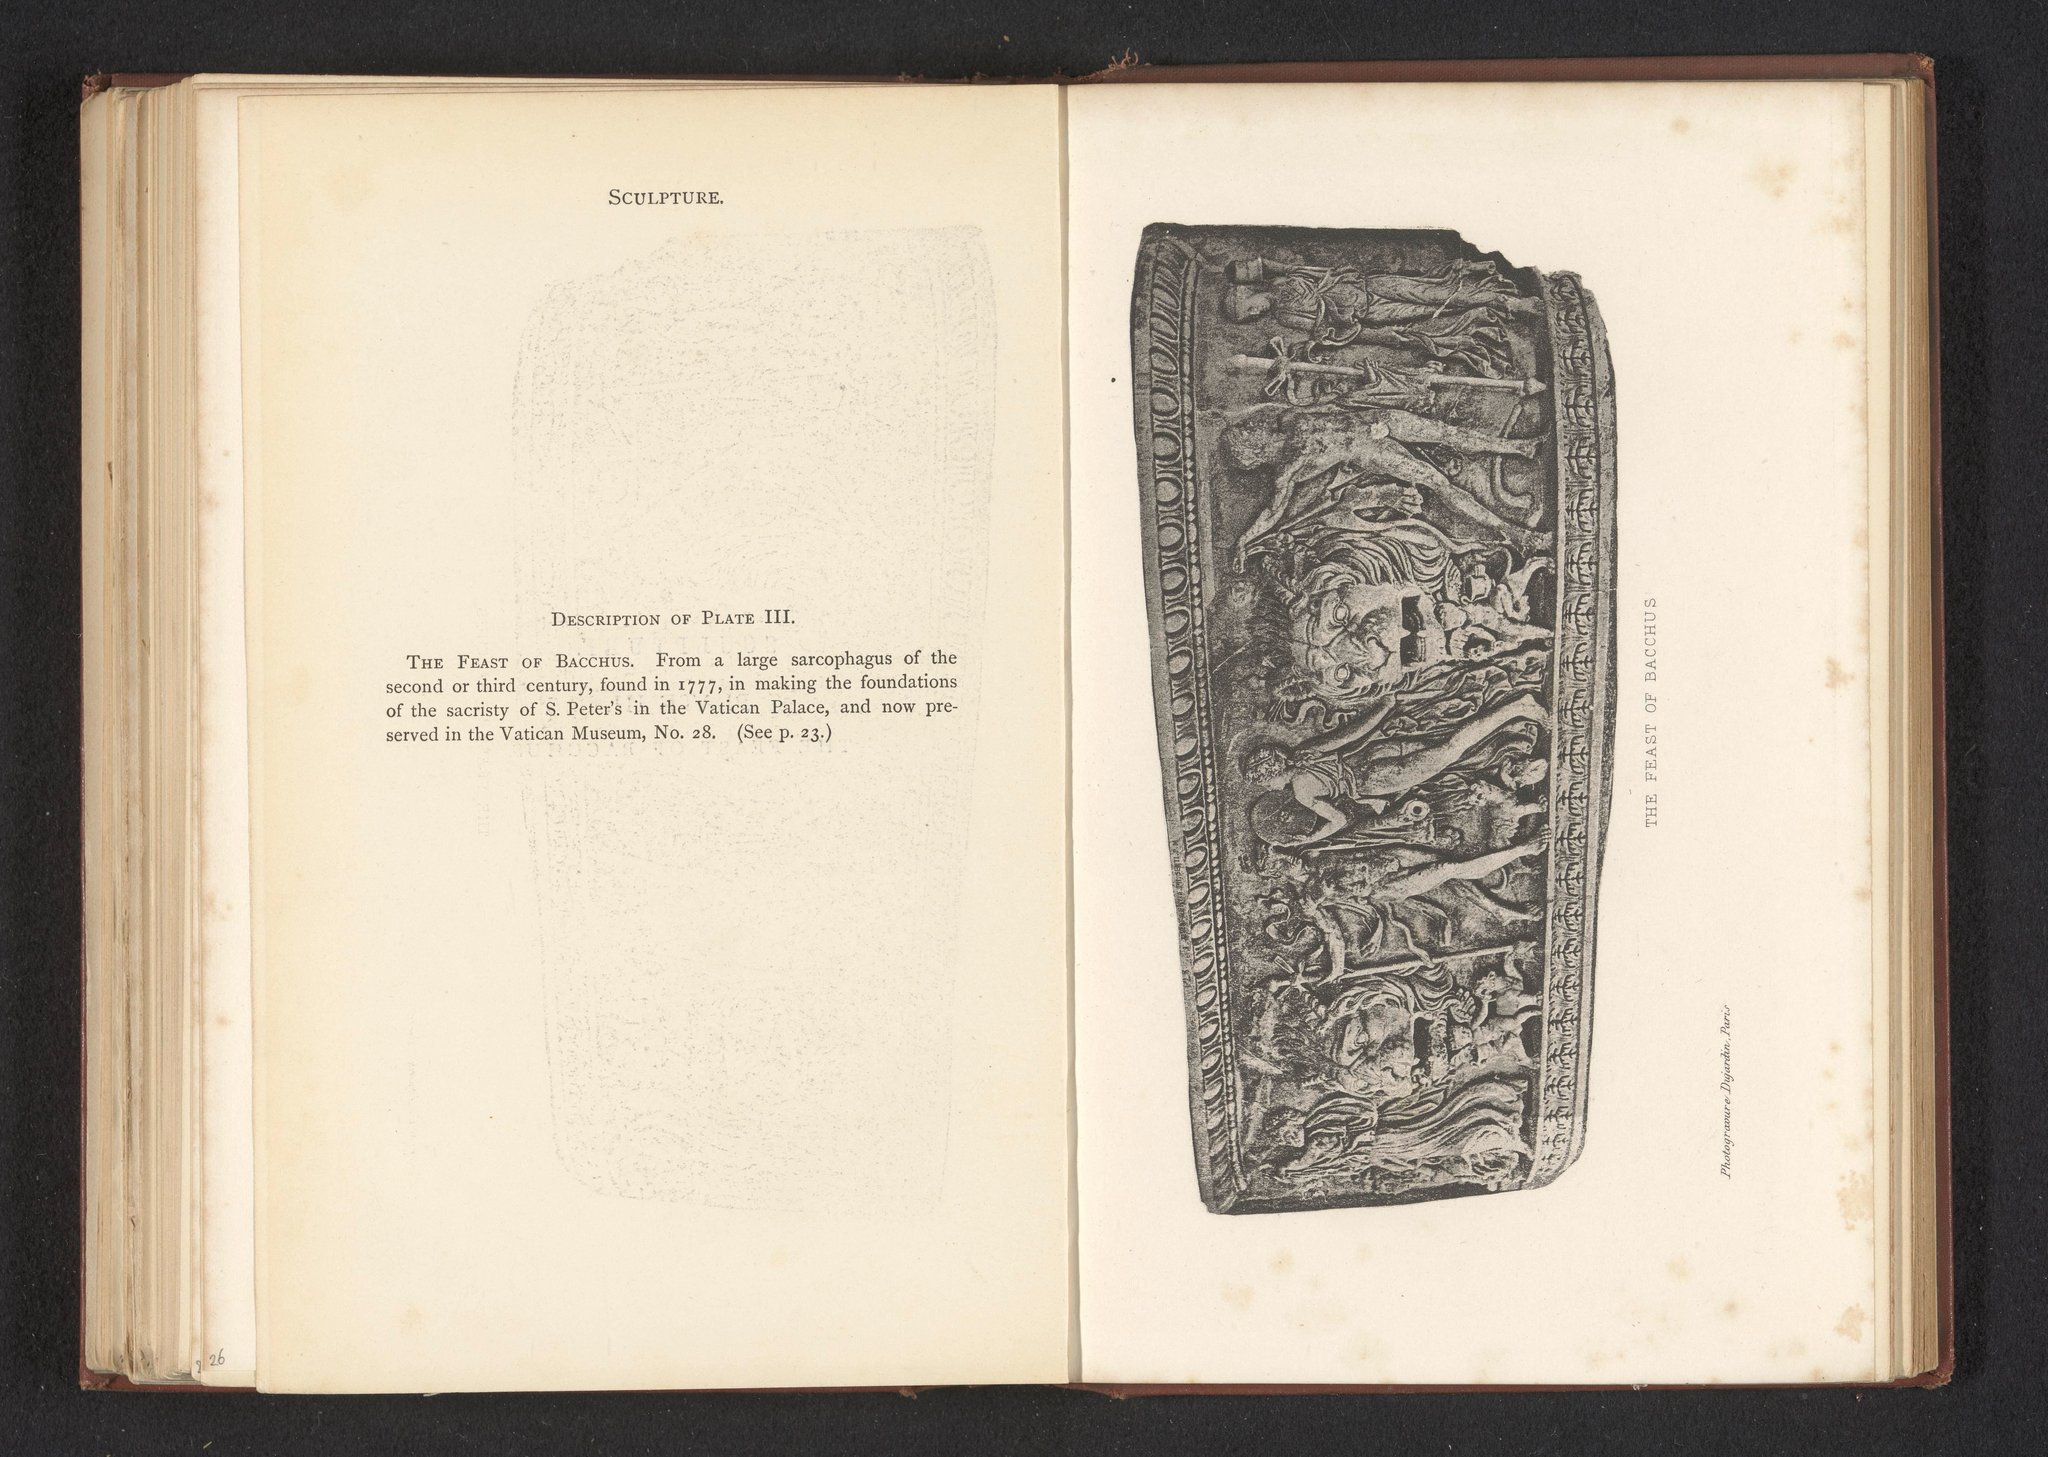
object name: page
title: Reliëf van een sarcofaag, voorstellend een bacchanaal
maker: Anonymous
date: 1867-1877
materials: paper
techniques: photoaquatint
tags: thiasos, i.e. bacchus' revel-rout, bacchanal without bacchus, sarcophagus, decorating 'en relief', appliquéing